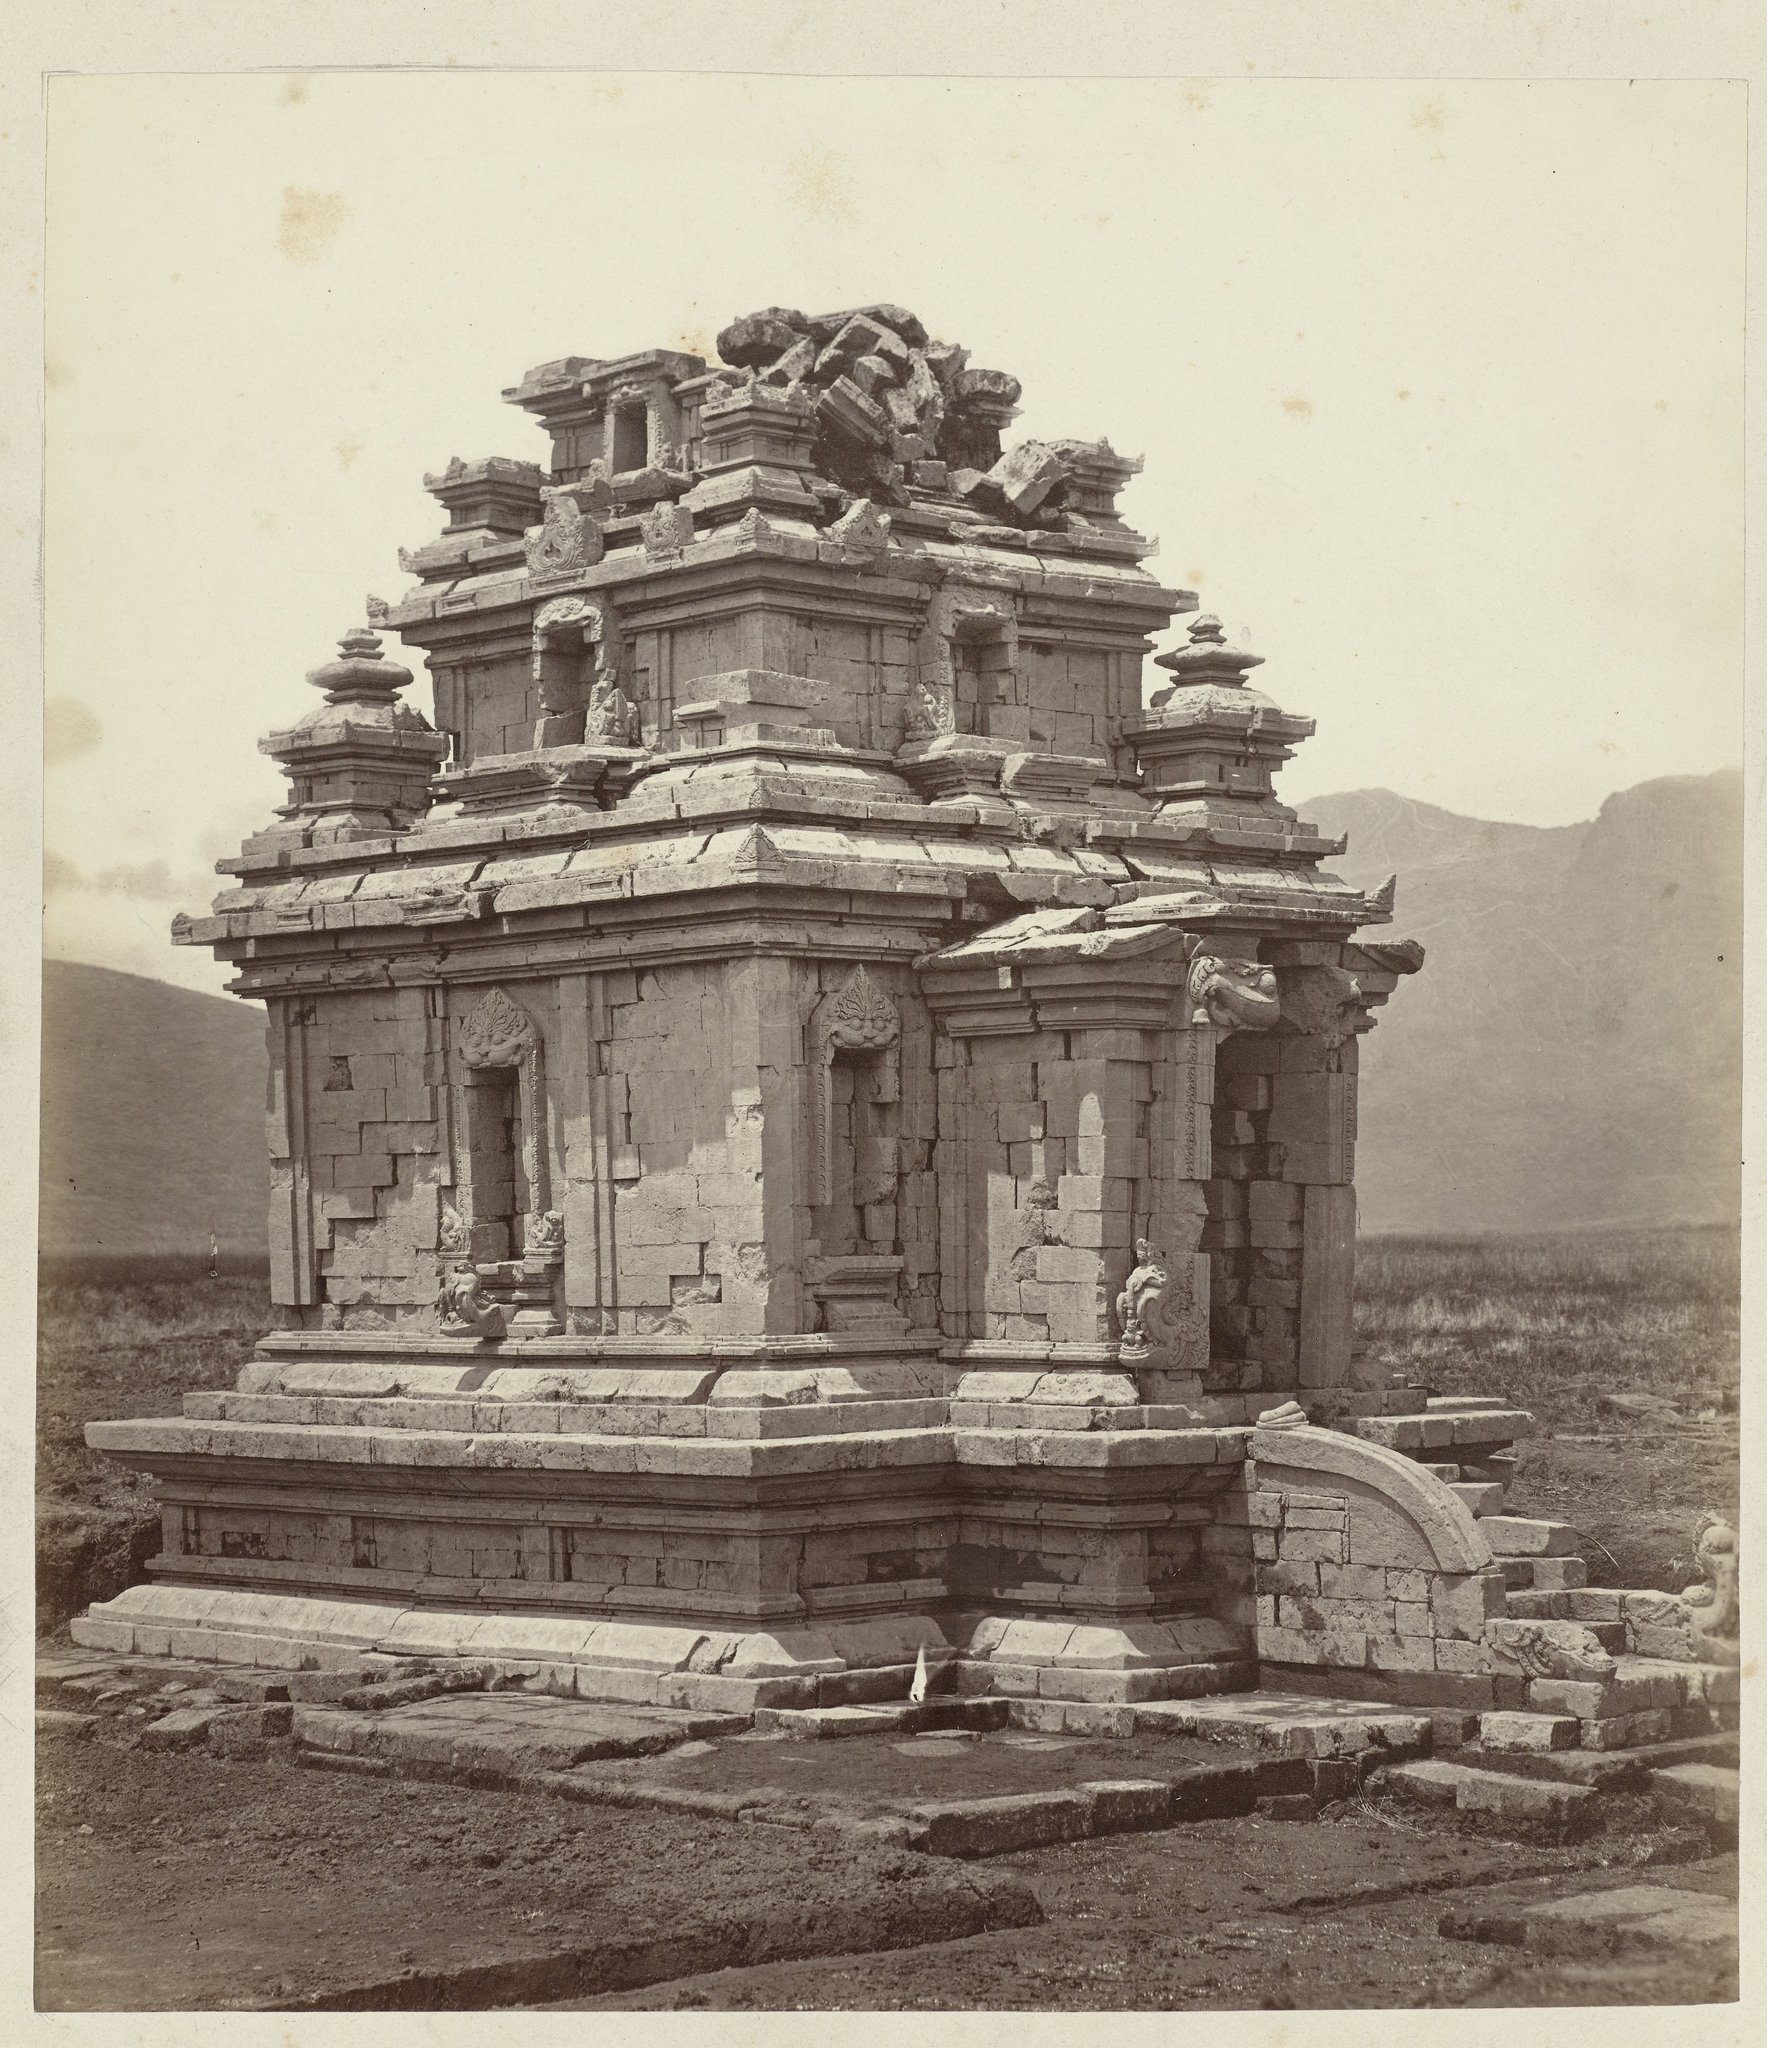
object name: photograph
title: Candi Arjuna, general view showing the staicase projection and the entrance (west). Dieng plateau, Wonosobo district, Central Java province, 8th-9th century.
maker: isidore kinsbergen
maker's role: fotograaf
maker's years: 1821-1905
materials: cardboard, paper, photographic support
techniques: albumen print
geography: java